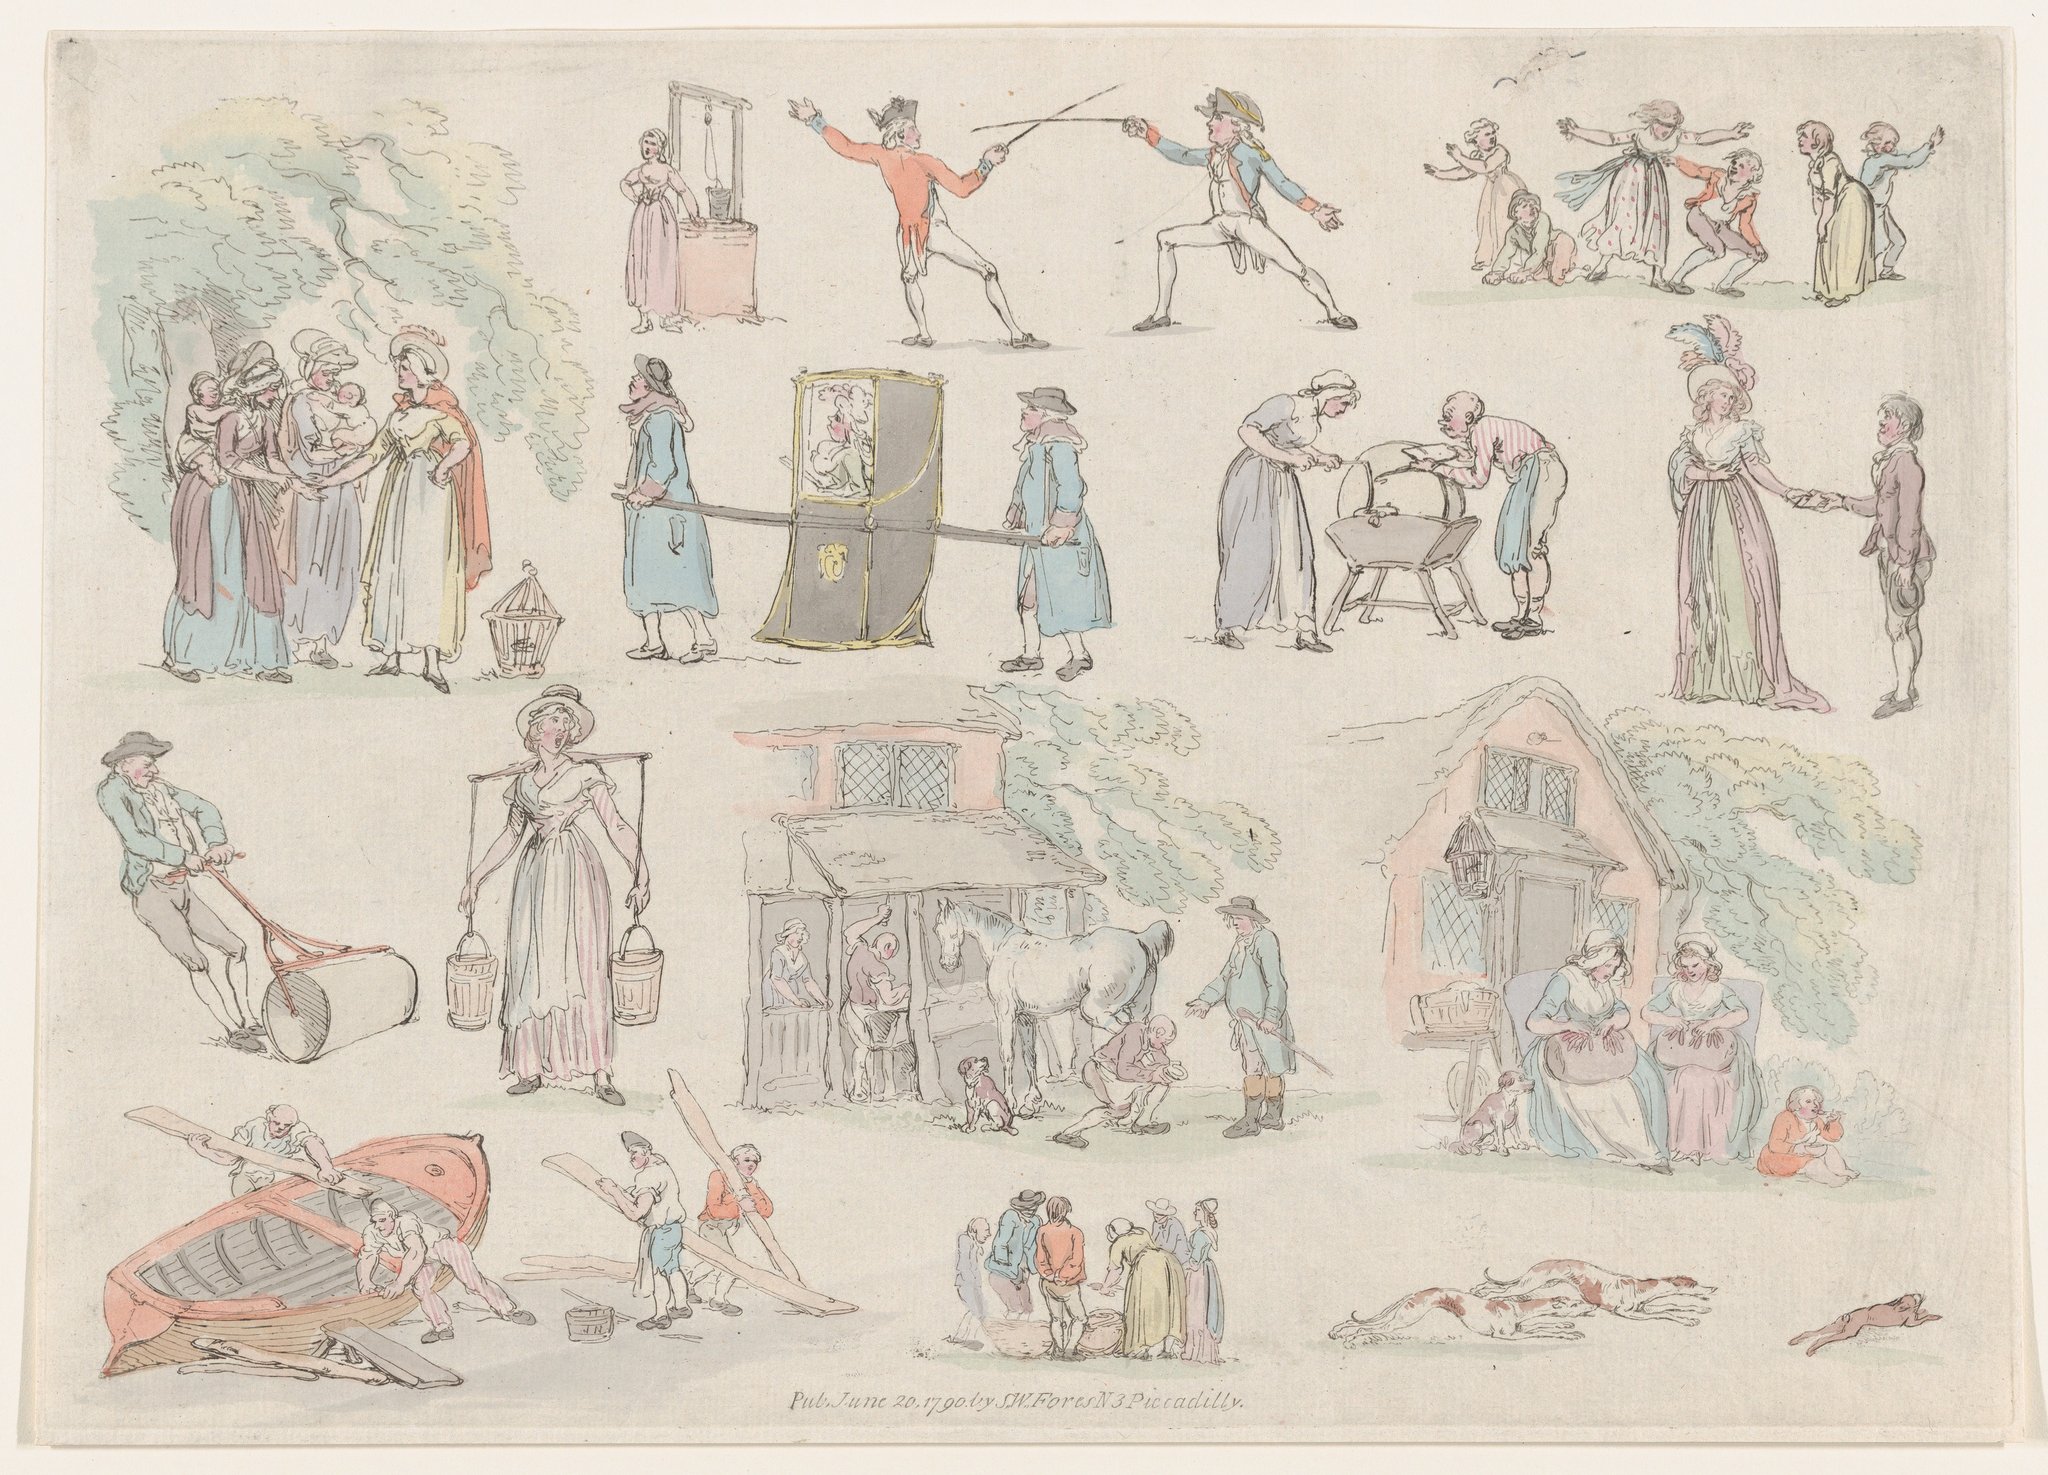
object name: print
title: Plate 8, Outlines of Figures, Landscapes and Cattle...for the Use of Learners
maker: thomas rowlandson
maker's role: artist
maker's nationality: british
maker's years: 1757-1827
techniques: etching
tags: men,women,horses,working,boats